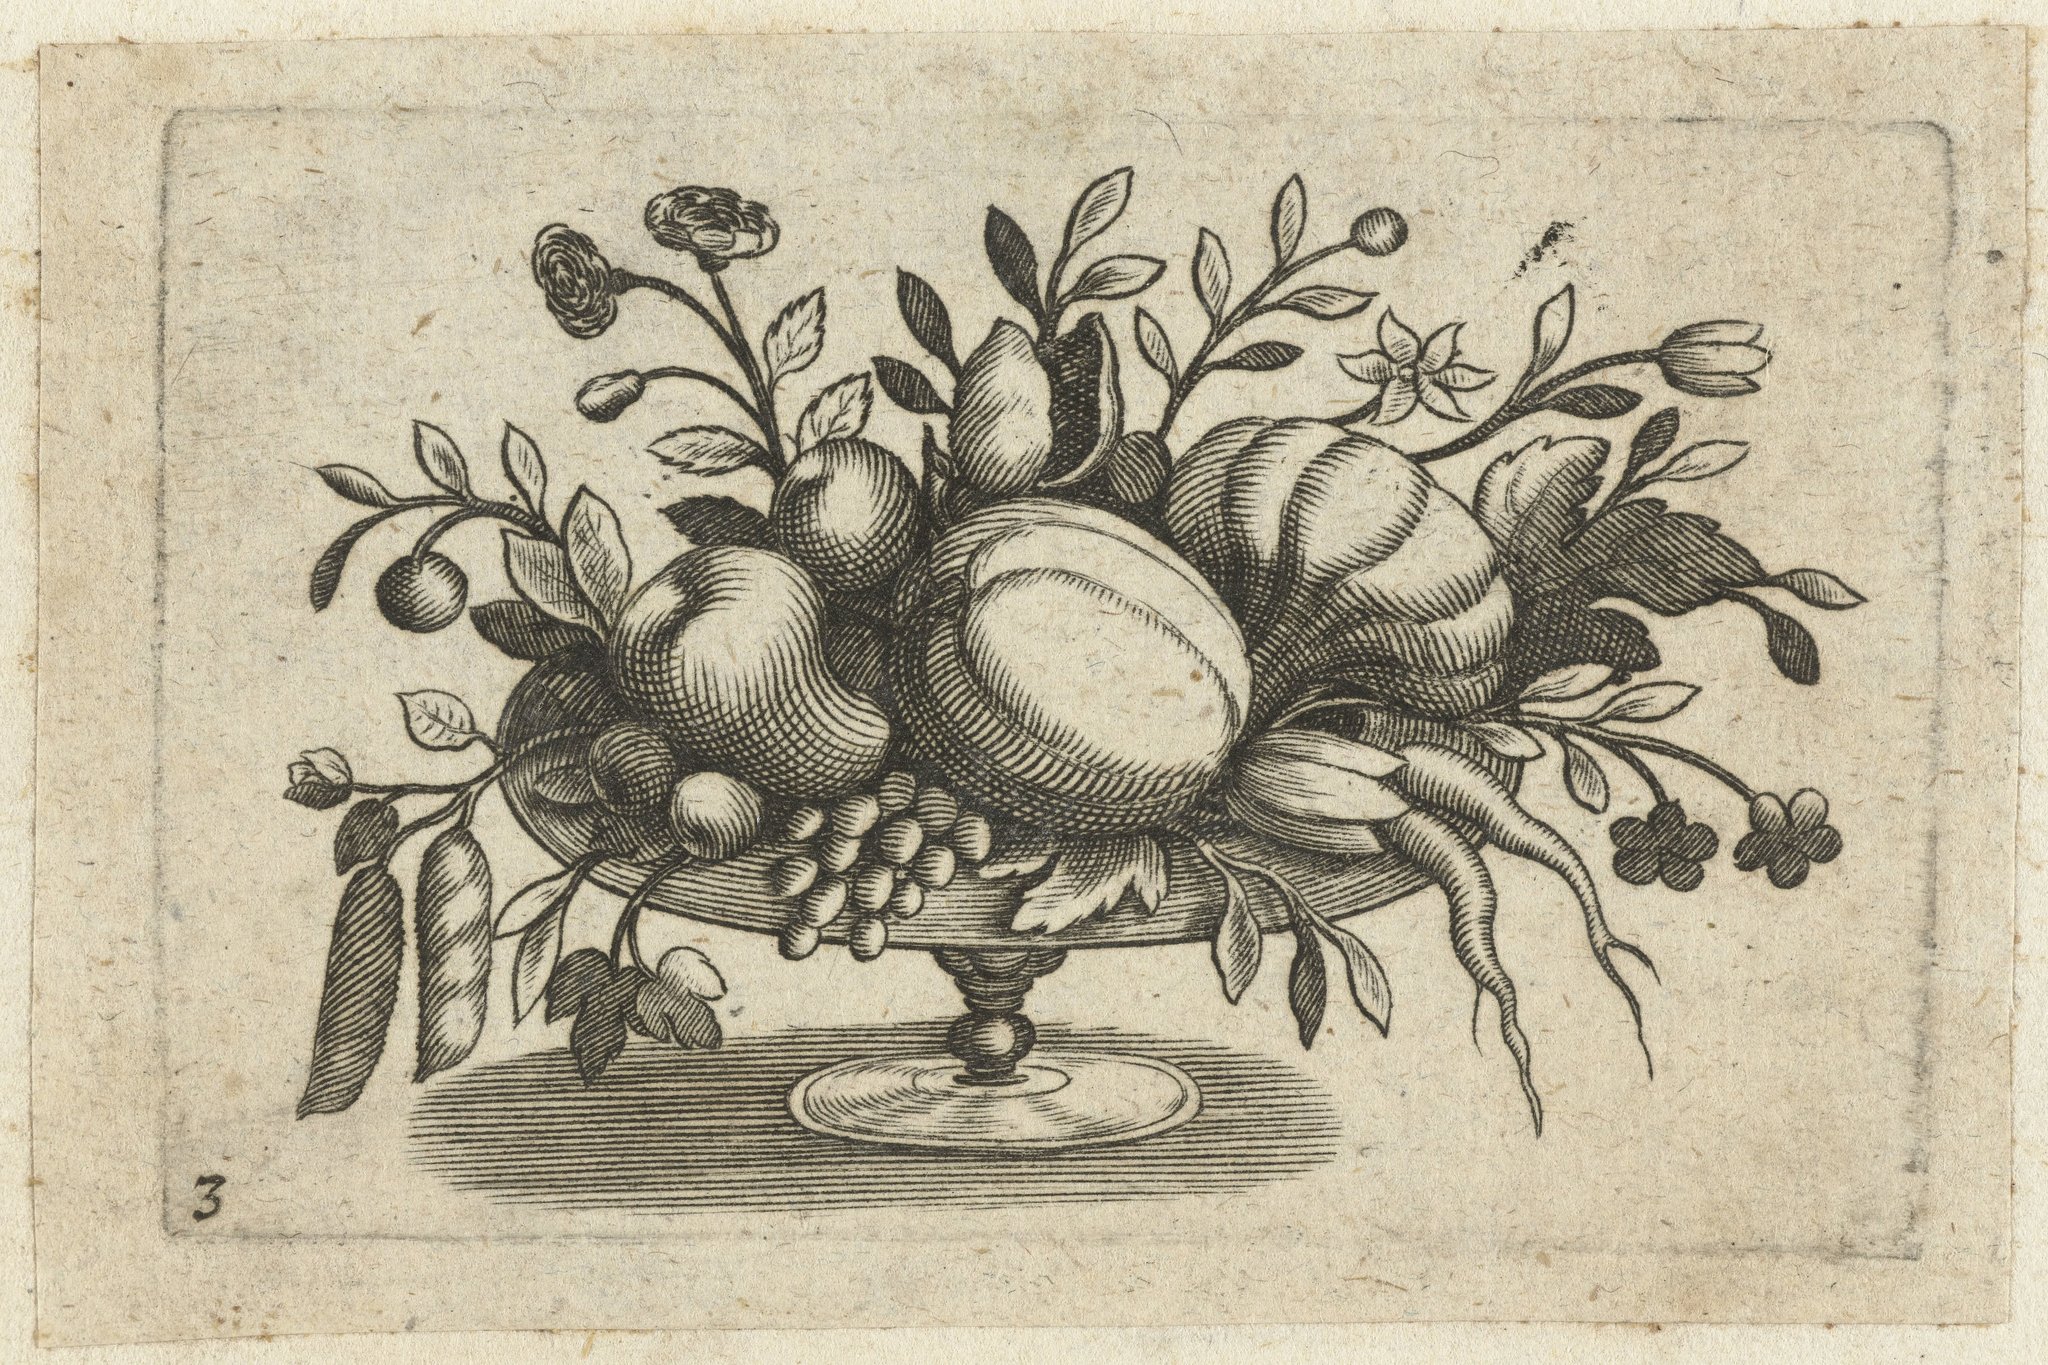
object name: ornament print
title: Fruchtenbuchlein zum Reisen dienlich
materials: paper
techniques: engraving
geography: germany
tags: fruits and vegetables ~ ornament, ornament ~ festoon, garland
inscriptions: number: ‘3’